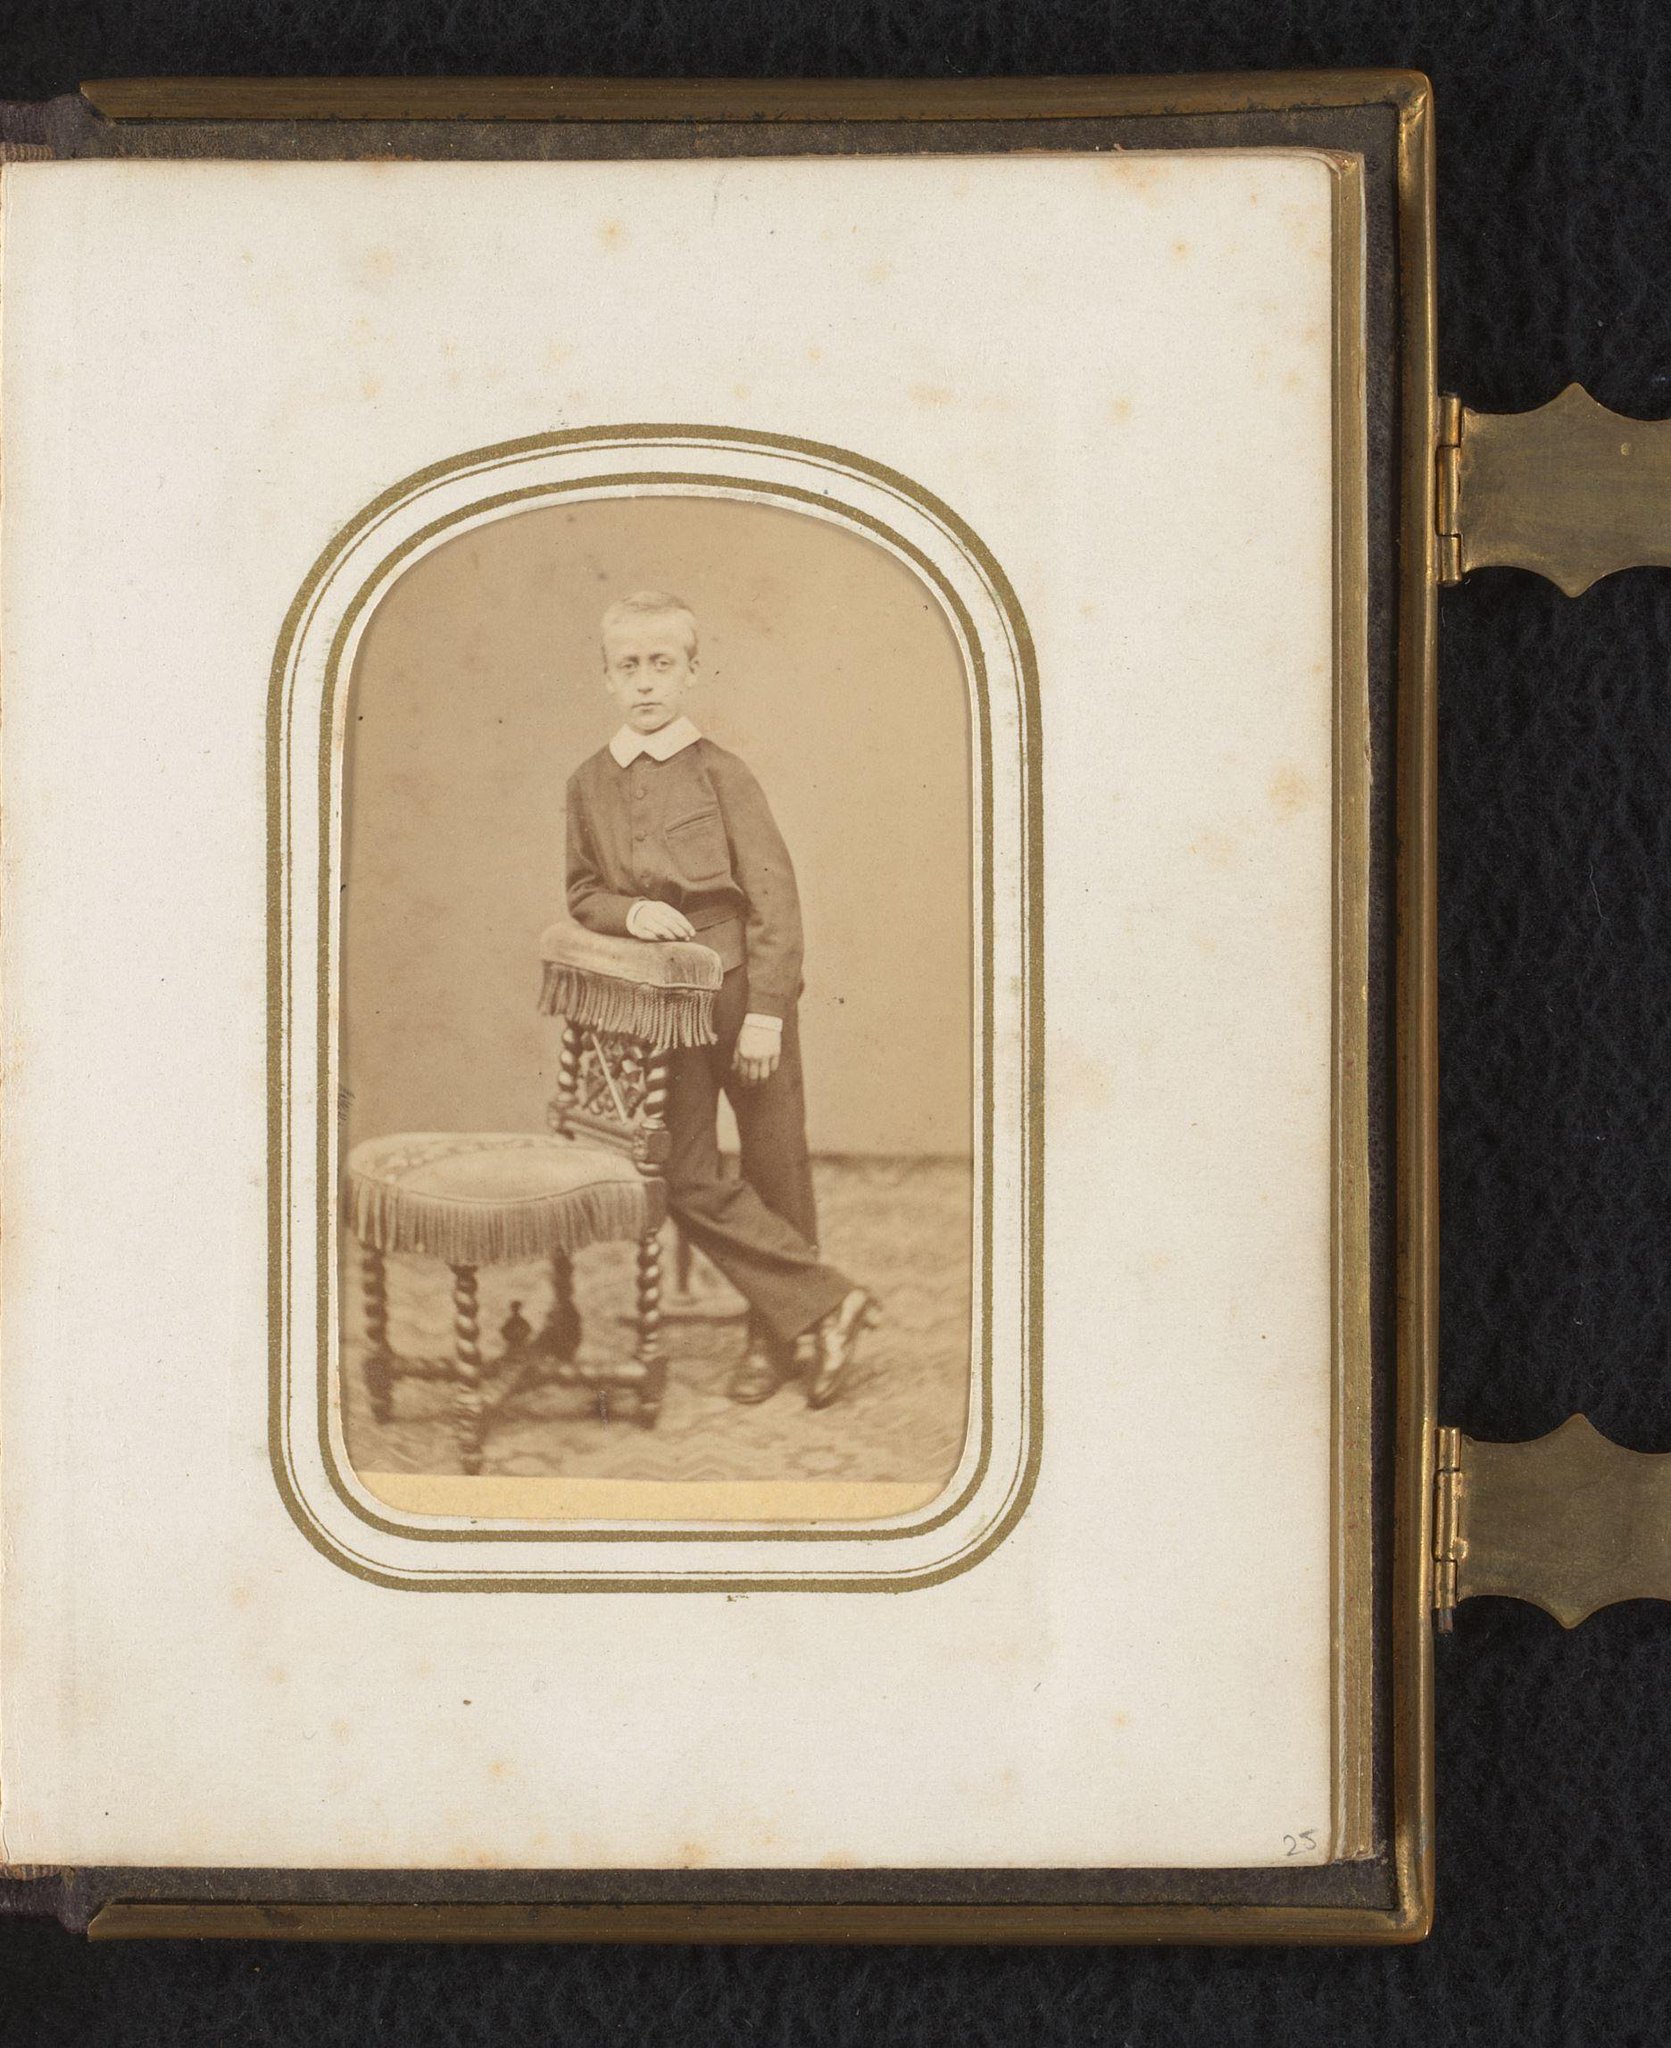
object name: photograph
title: Portret van een jongen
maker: hermanus jodocus weesing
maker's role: fotograaf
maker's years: 1844-1910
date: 1865-1900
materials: cardboard, photographic support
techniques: albumen print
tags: boy (child between toddler and youth), historical persons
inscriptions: inscription: ‘H.J. Weesing/ Photograaf/ Binnen Brouwerstraat 5/ Amsterdam’